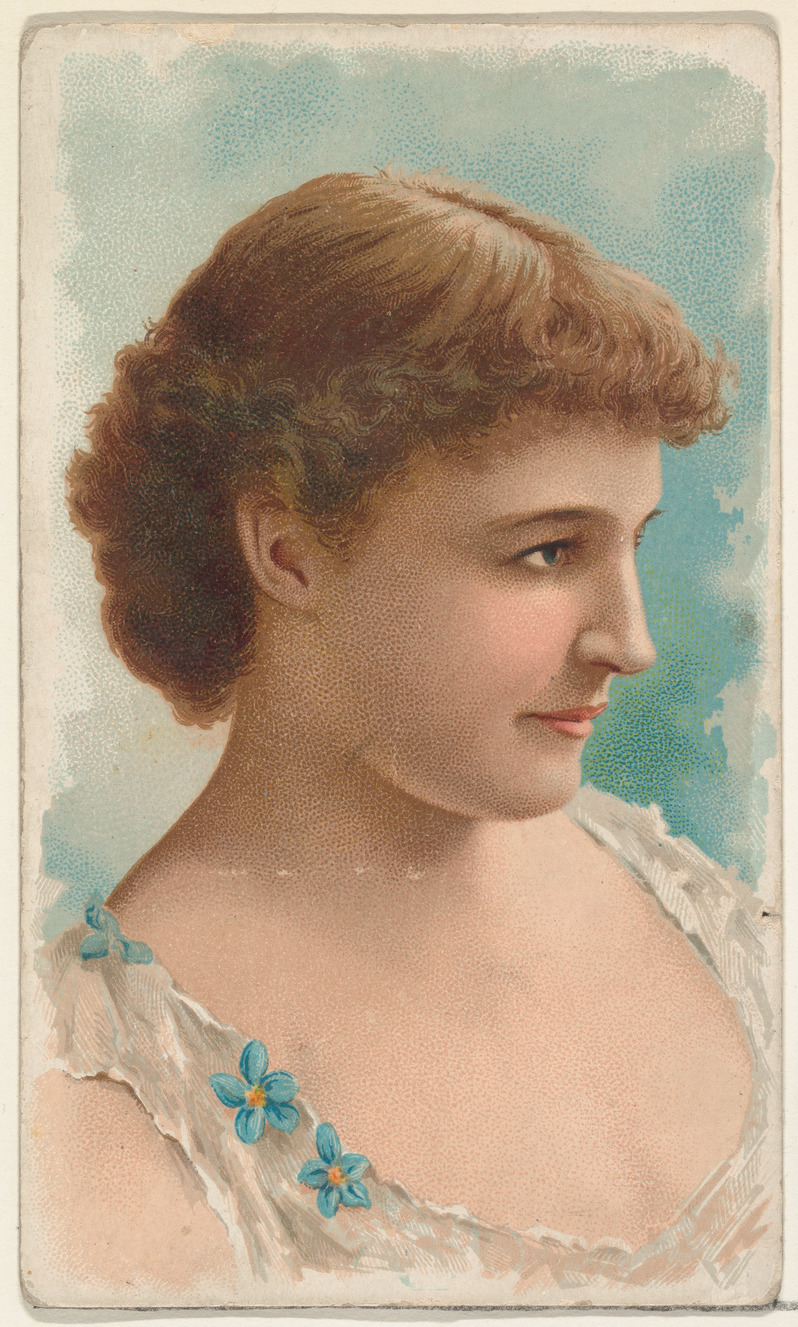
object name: print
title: Actress wearing white sleeveless bodice with blue floral details, from Stars of the Stage, First Series (N129) issued by W. Duke, Sons & Co. to promote Honest Long Cut Tobacco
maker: w. duke, sons & co.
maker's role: publisher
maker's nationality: american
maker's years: 1870-1920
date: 1890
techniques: color lithograph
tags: profiles,women,actresses